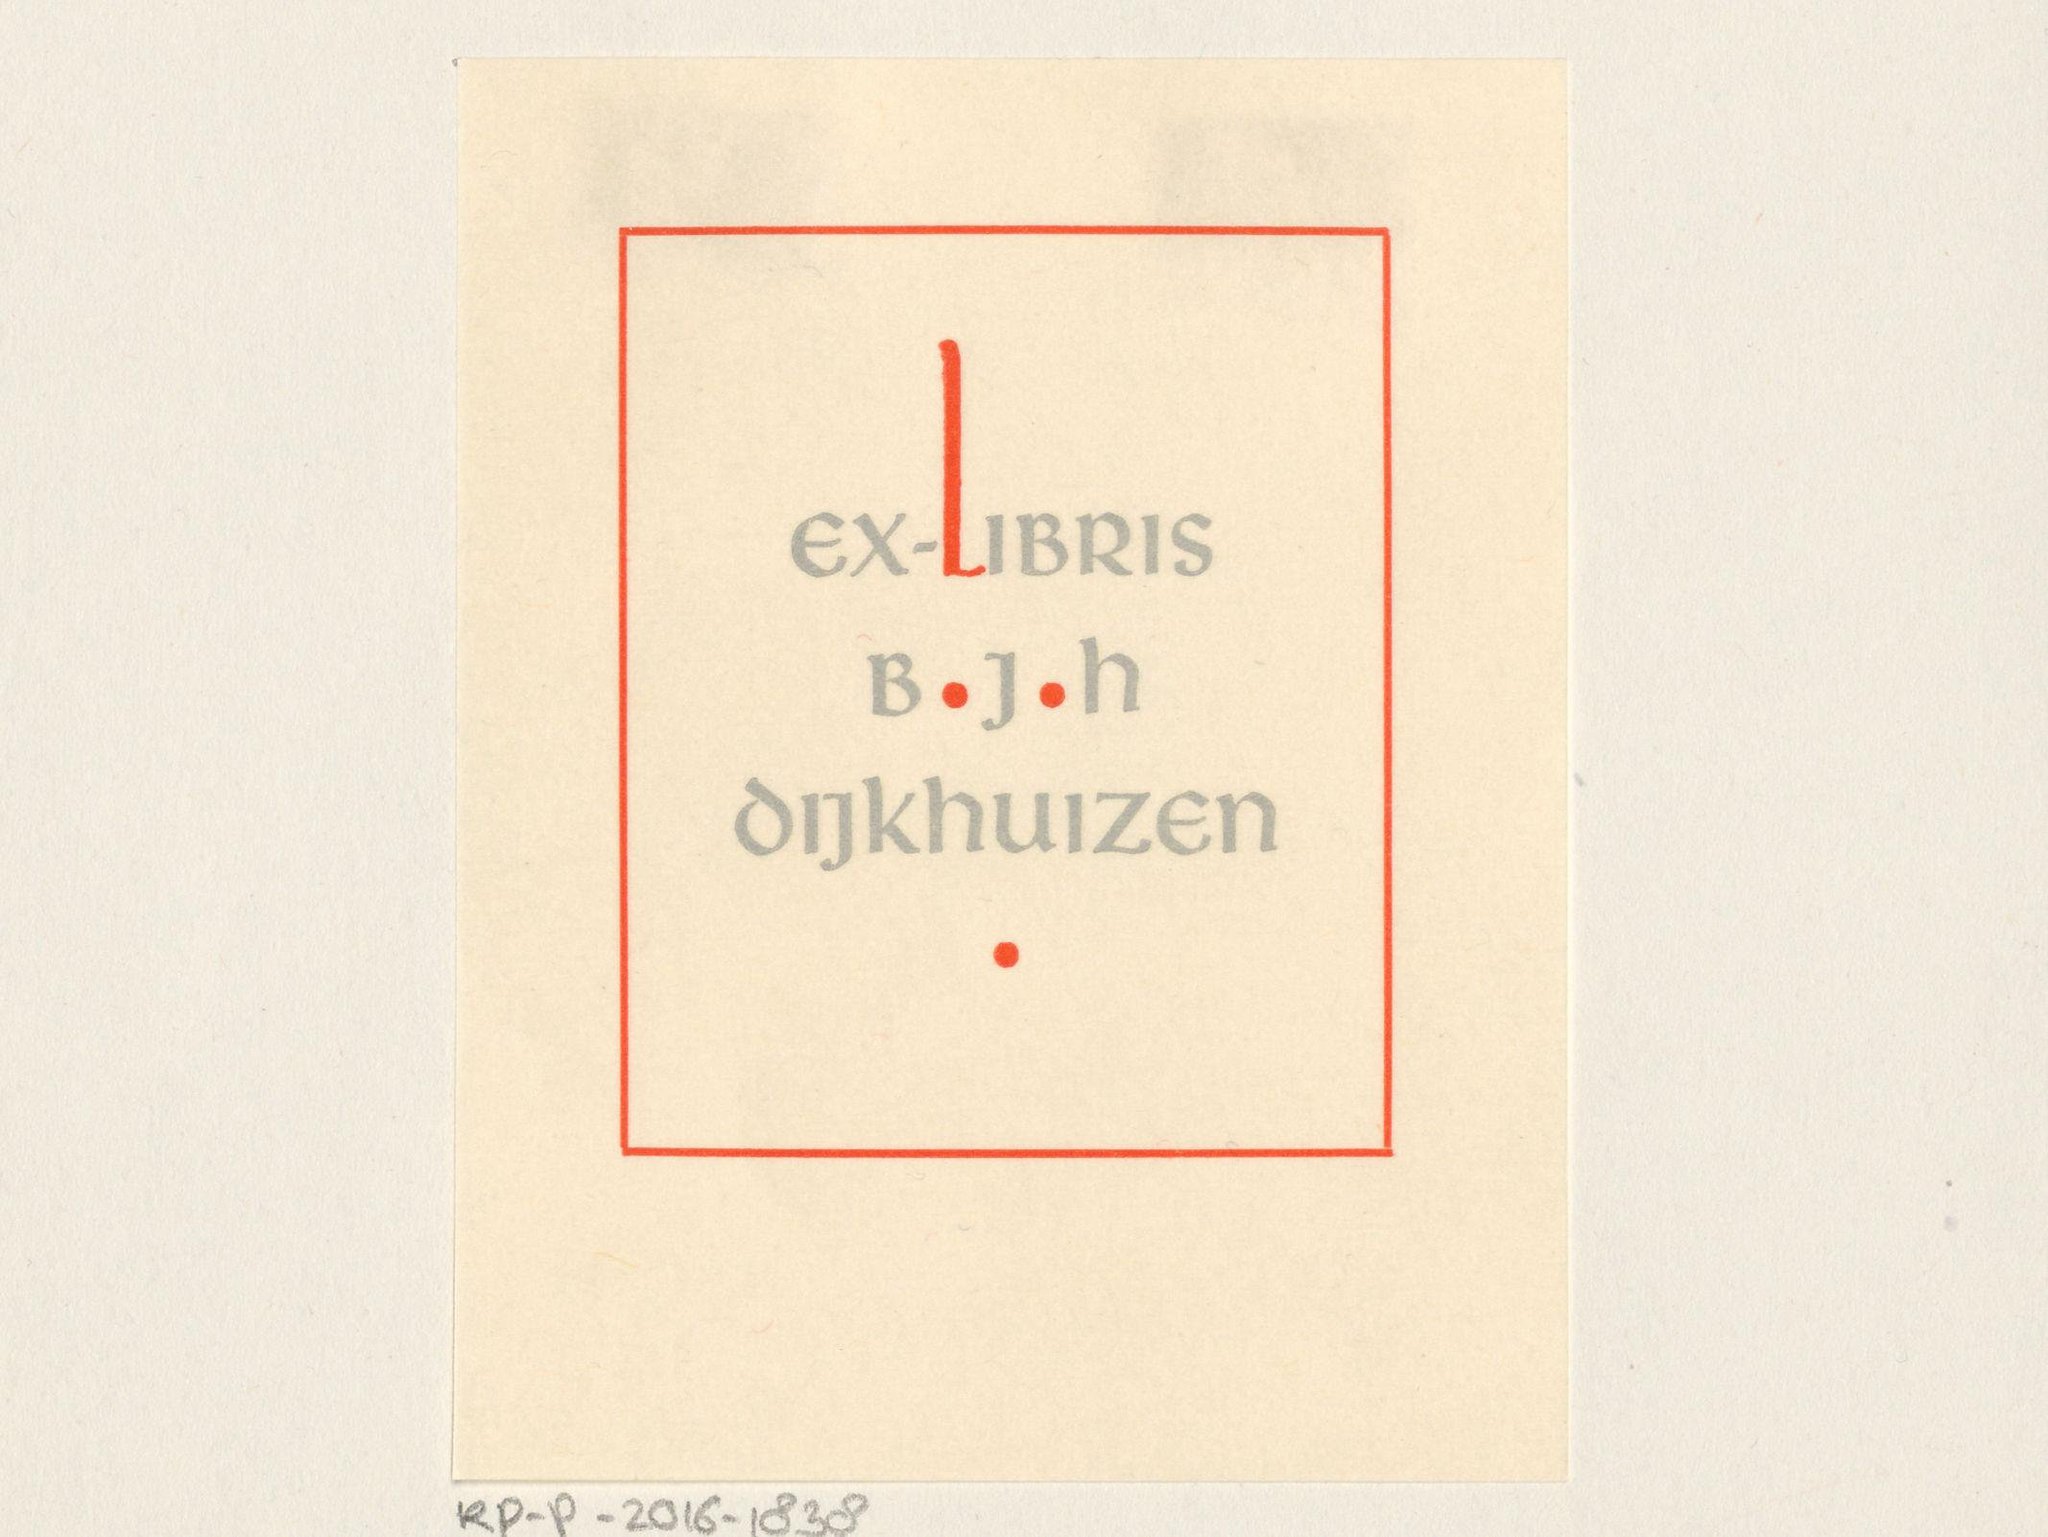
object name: bookplate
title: Ex libris van B.J.H. Dijkhuizen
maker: b. timmer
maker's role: print maker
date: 1940-1960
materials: paper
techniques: printing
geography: netherlands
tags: b.j.h. dijkhuizen